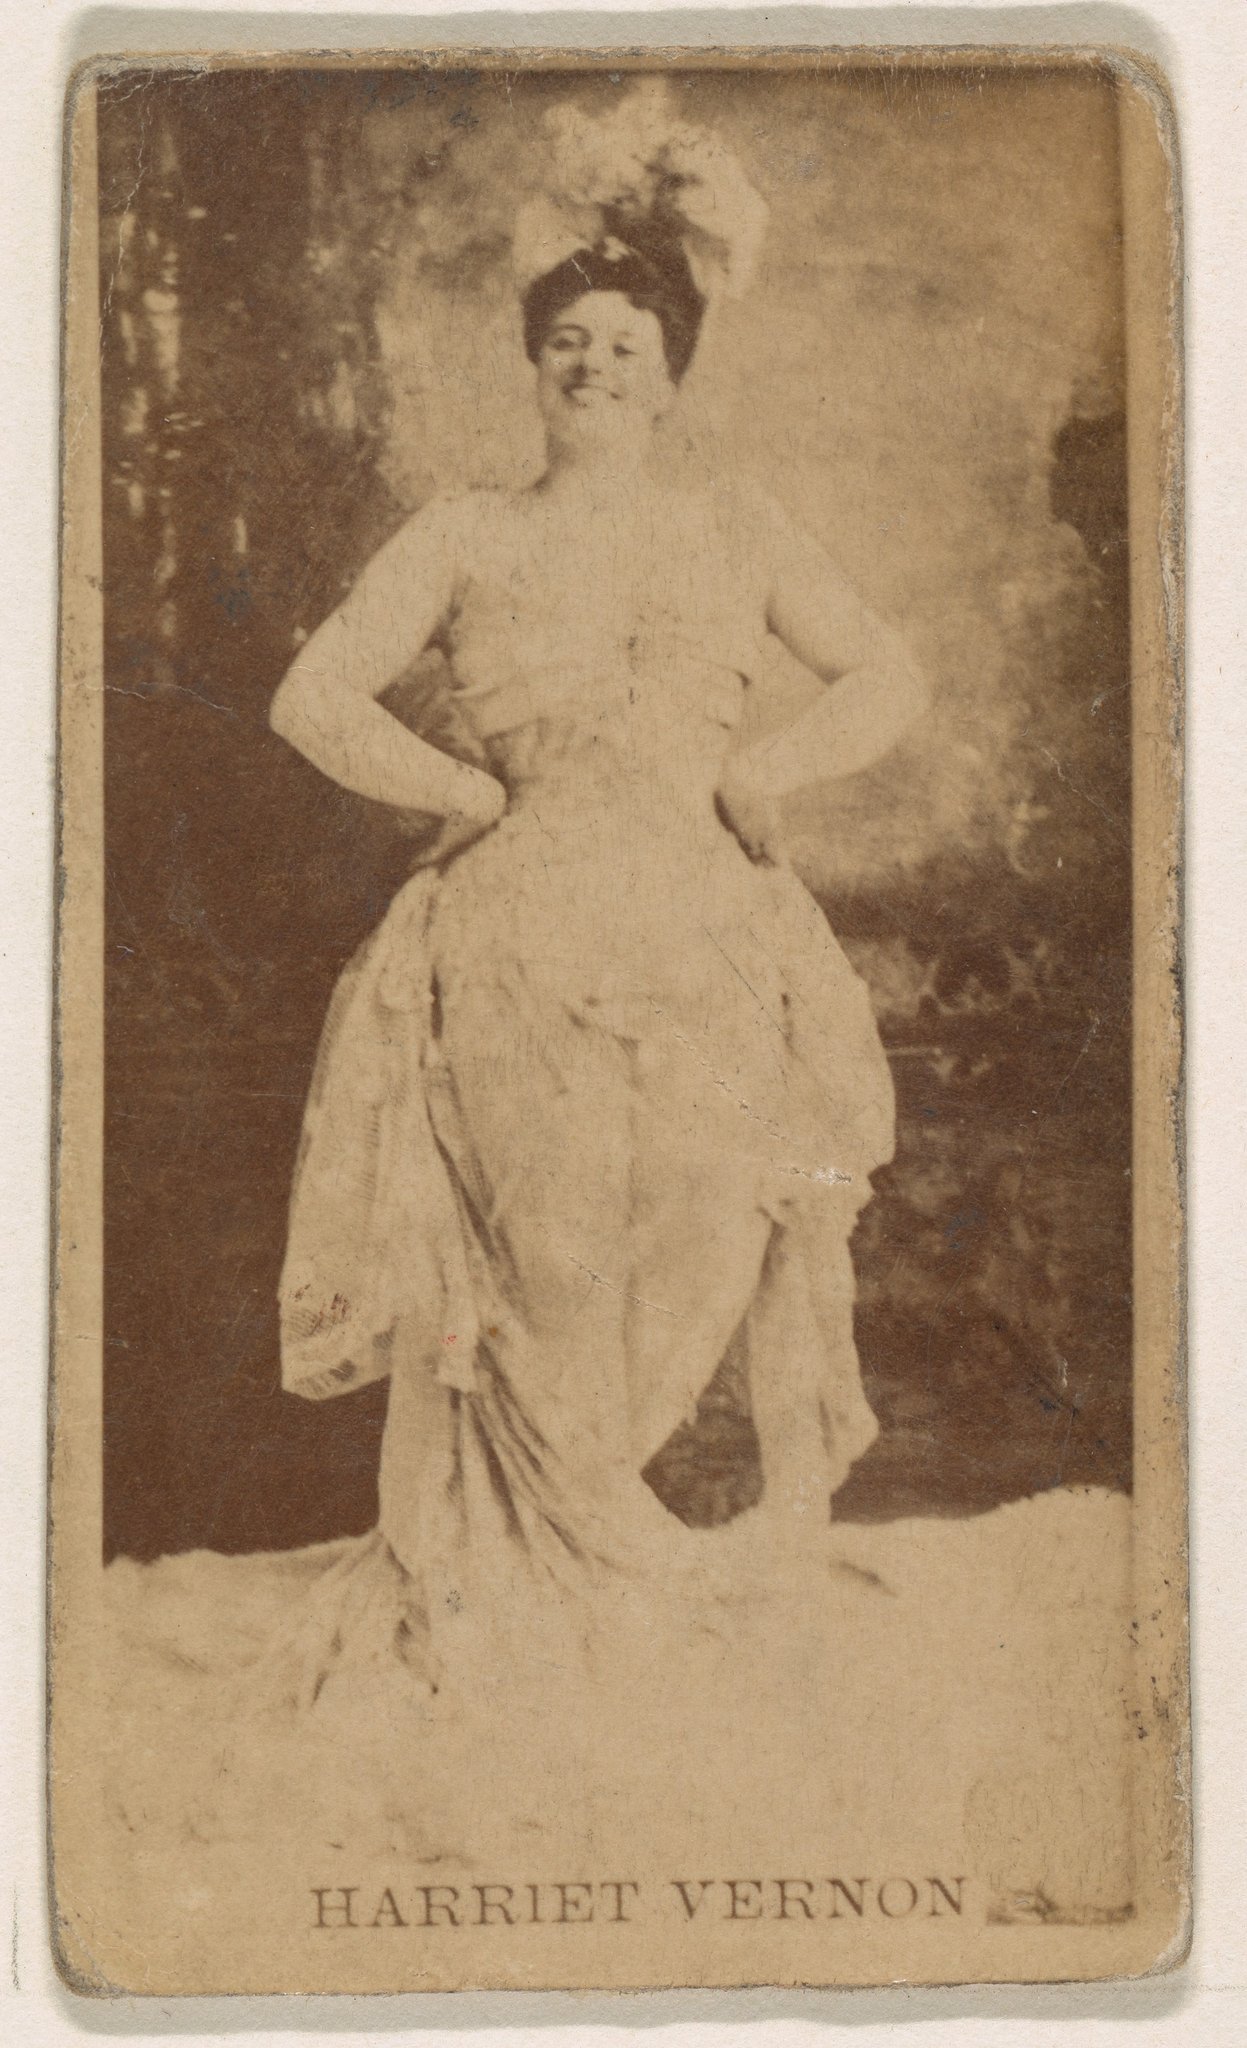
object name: photograph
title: Harriet Vernon, from the Actresses series (N245) issued by Kinney Brothers to promote Sweet Caporal Cigarettes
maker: kinney brothers tobacco company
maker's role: publisher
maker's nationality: american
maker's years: 1869-2011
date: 1890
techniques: albumen silver print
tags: portraits,women,actresses